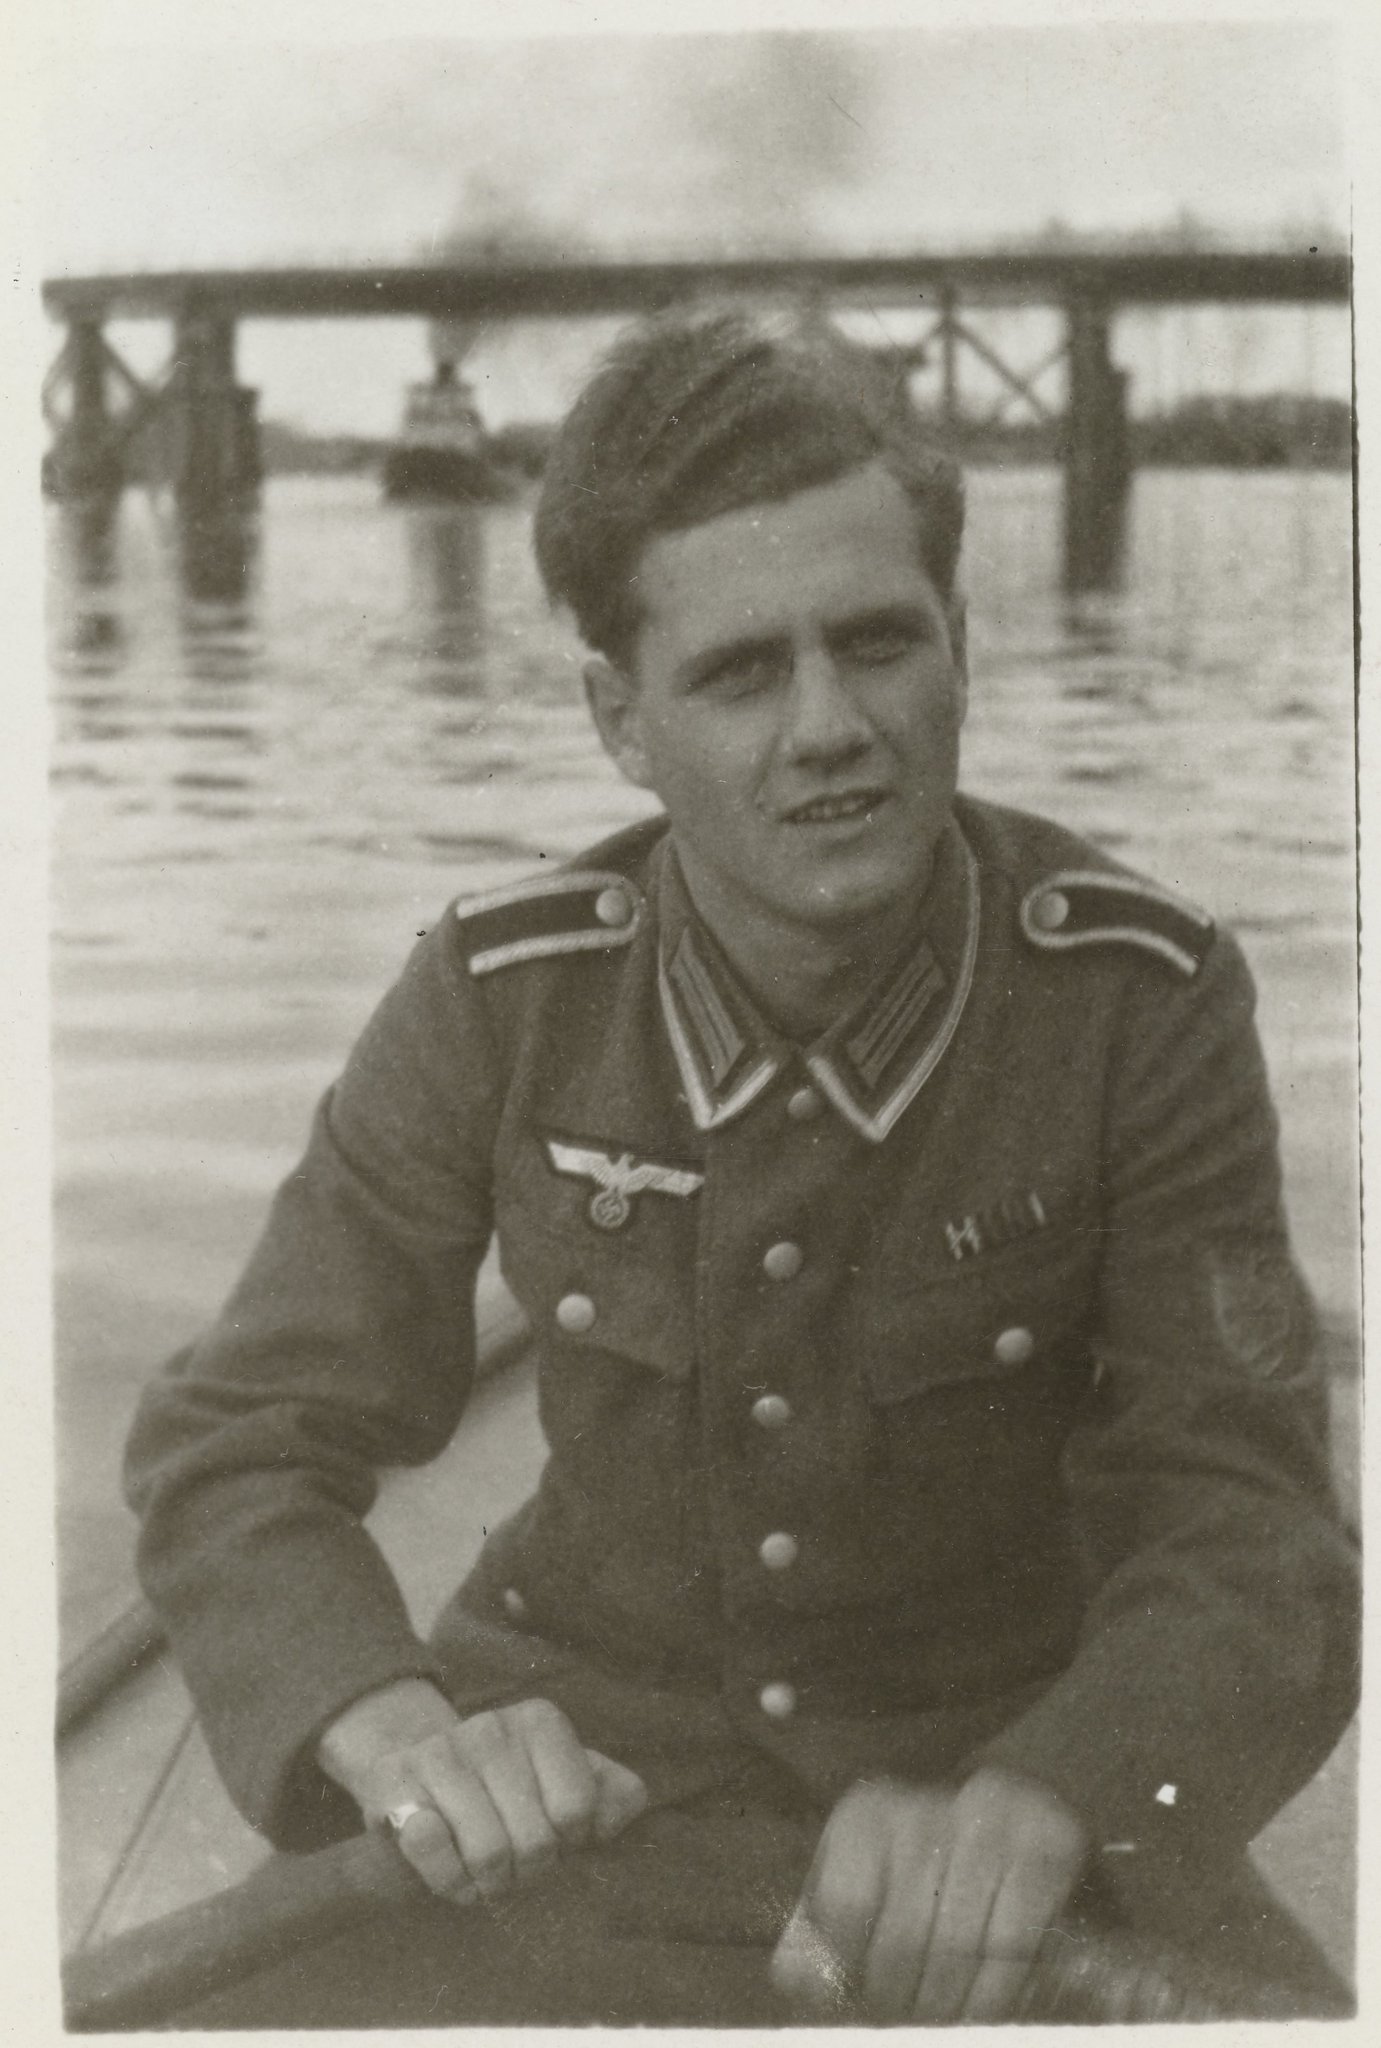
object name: photograph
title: Een lid van de Wehrmacht in een roeiboot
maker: Anonymous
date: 1940-1945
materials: photographic support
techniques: gelatin silver print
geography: germany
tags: netherlands, germany, france, belgium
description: Militair van de Wehrmacht in een roeiboot, achter hem een brug en een boot. Foto behorend bij album 'Kriegserinnerungen'.